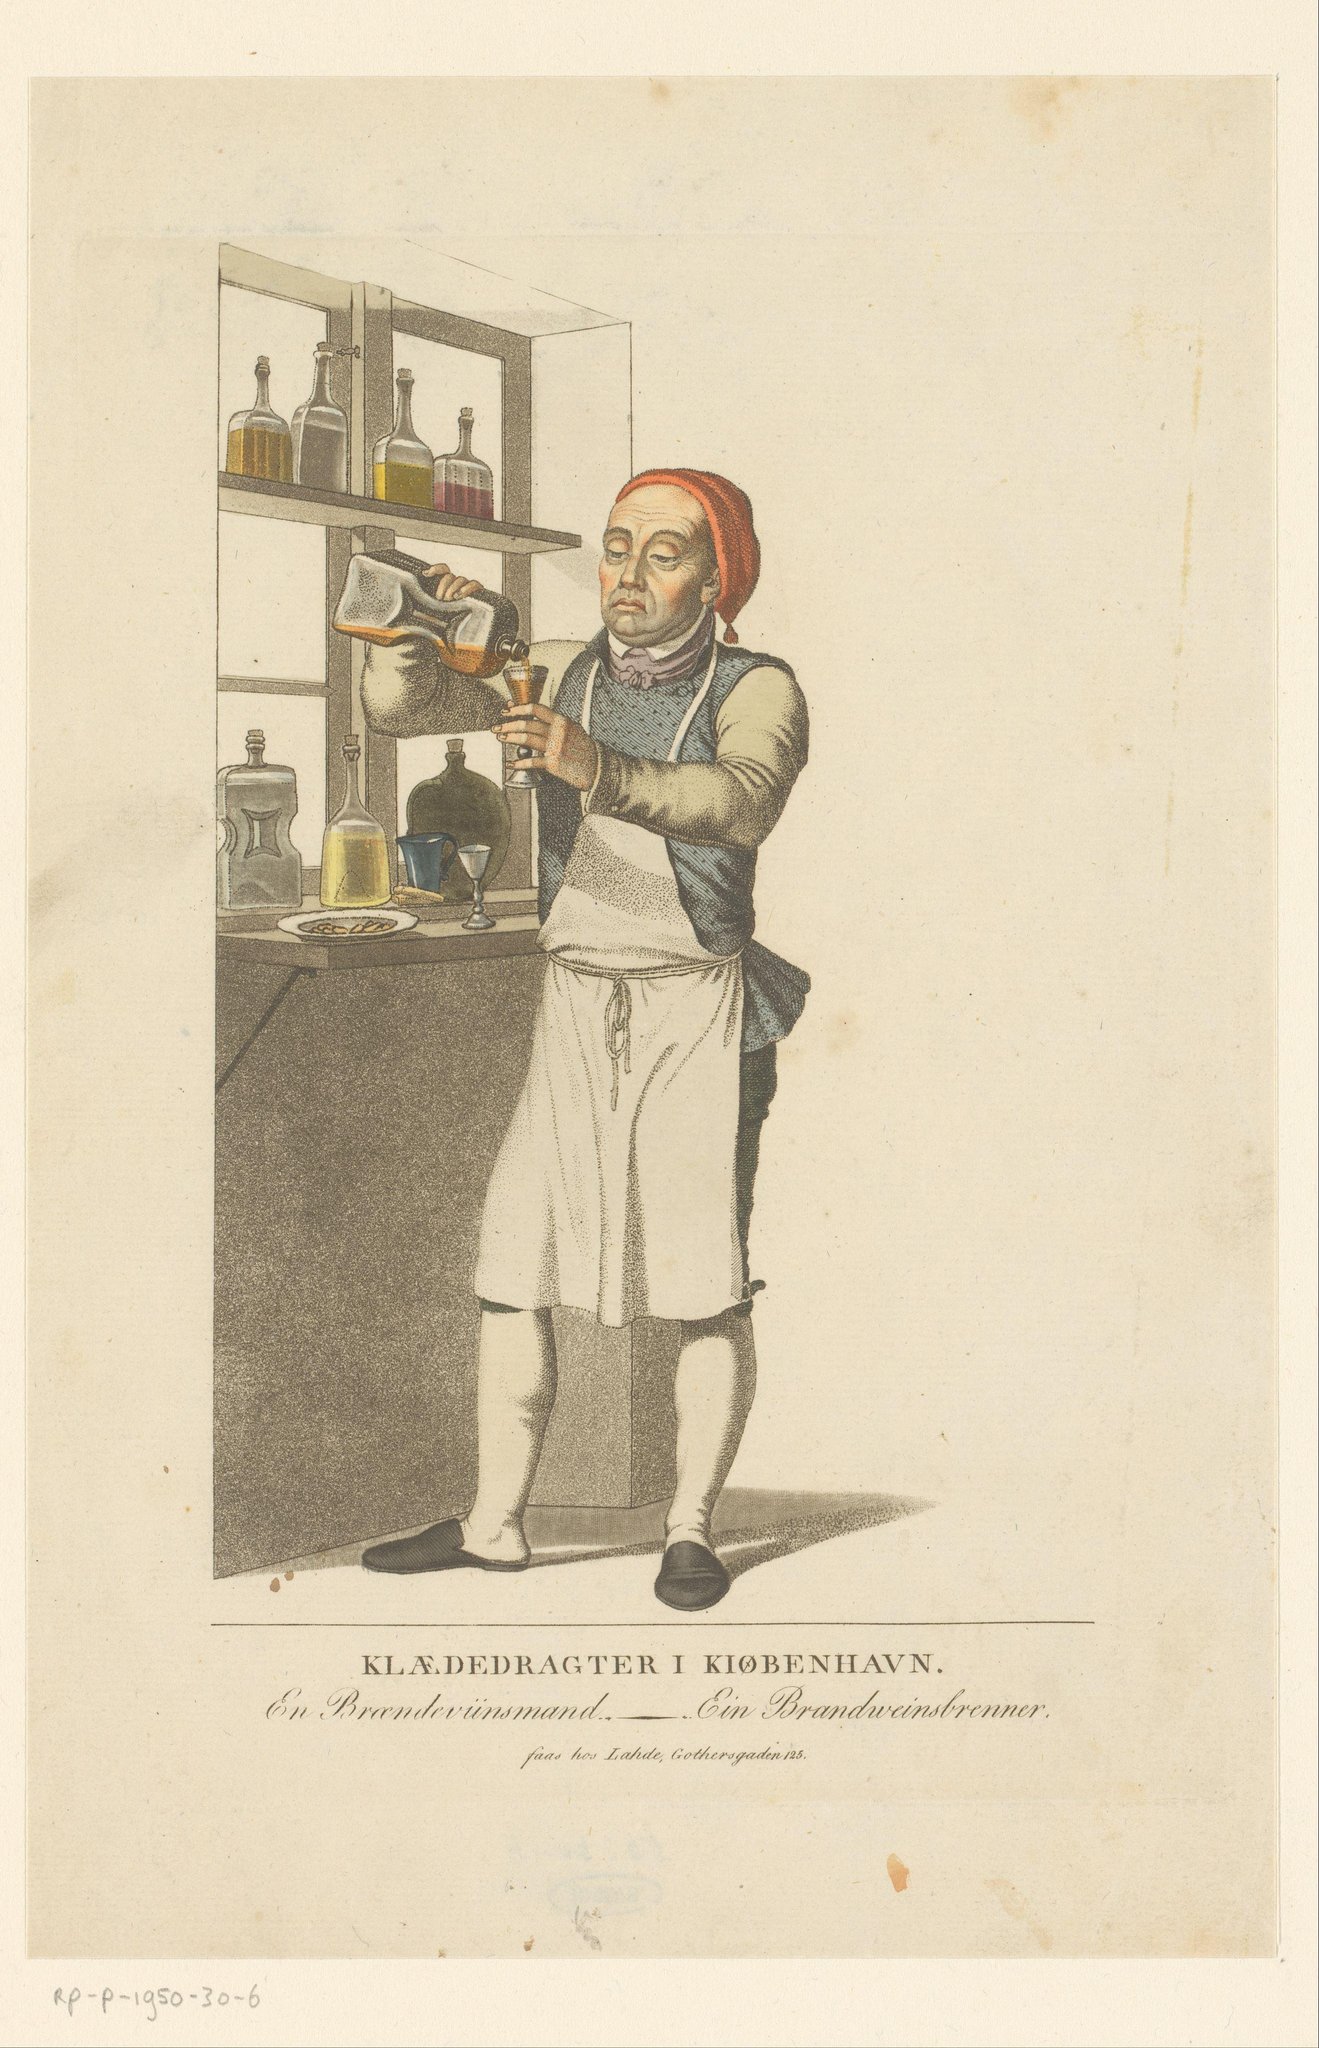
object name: print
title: En Braendevünsmand / Ein Brandweinsbrenner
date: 1805-1833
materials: paper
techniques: aquatint, etching, hand coloring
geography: copenhagen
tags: brandy, brandywine, folk costume, regional costume, copenhagen (city)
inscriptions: collector's mark: Lugt 2228